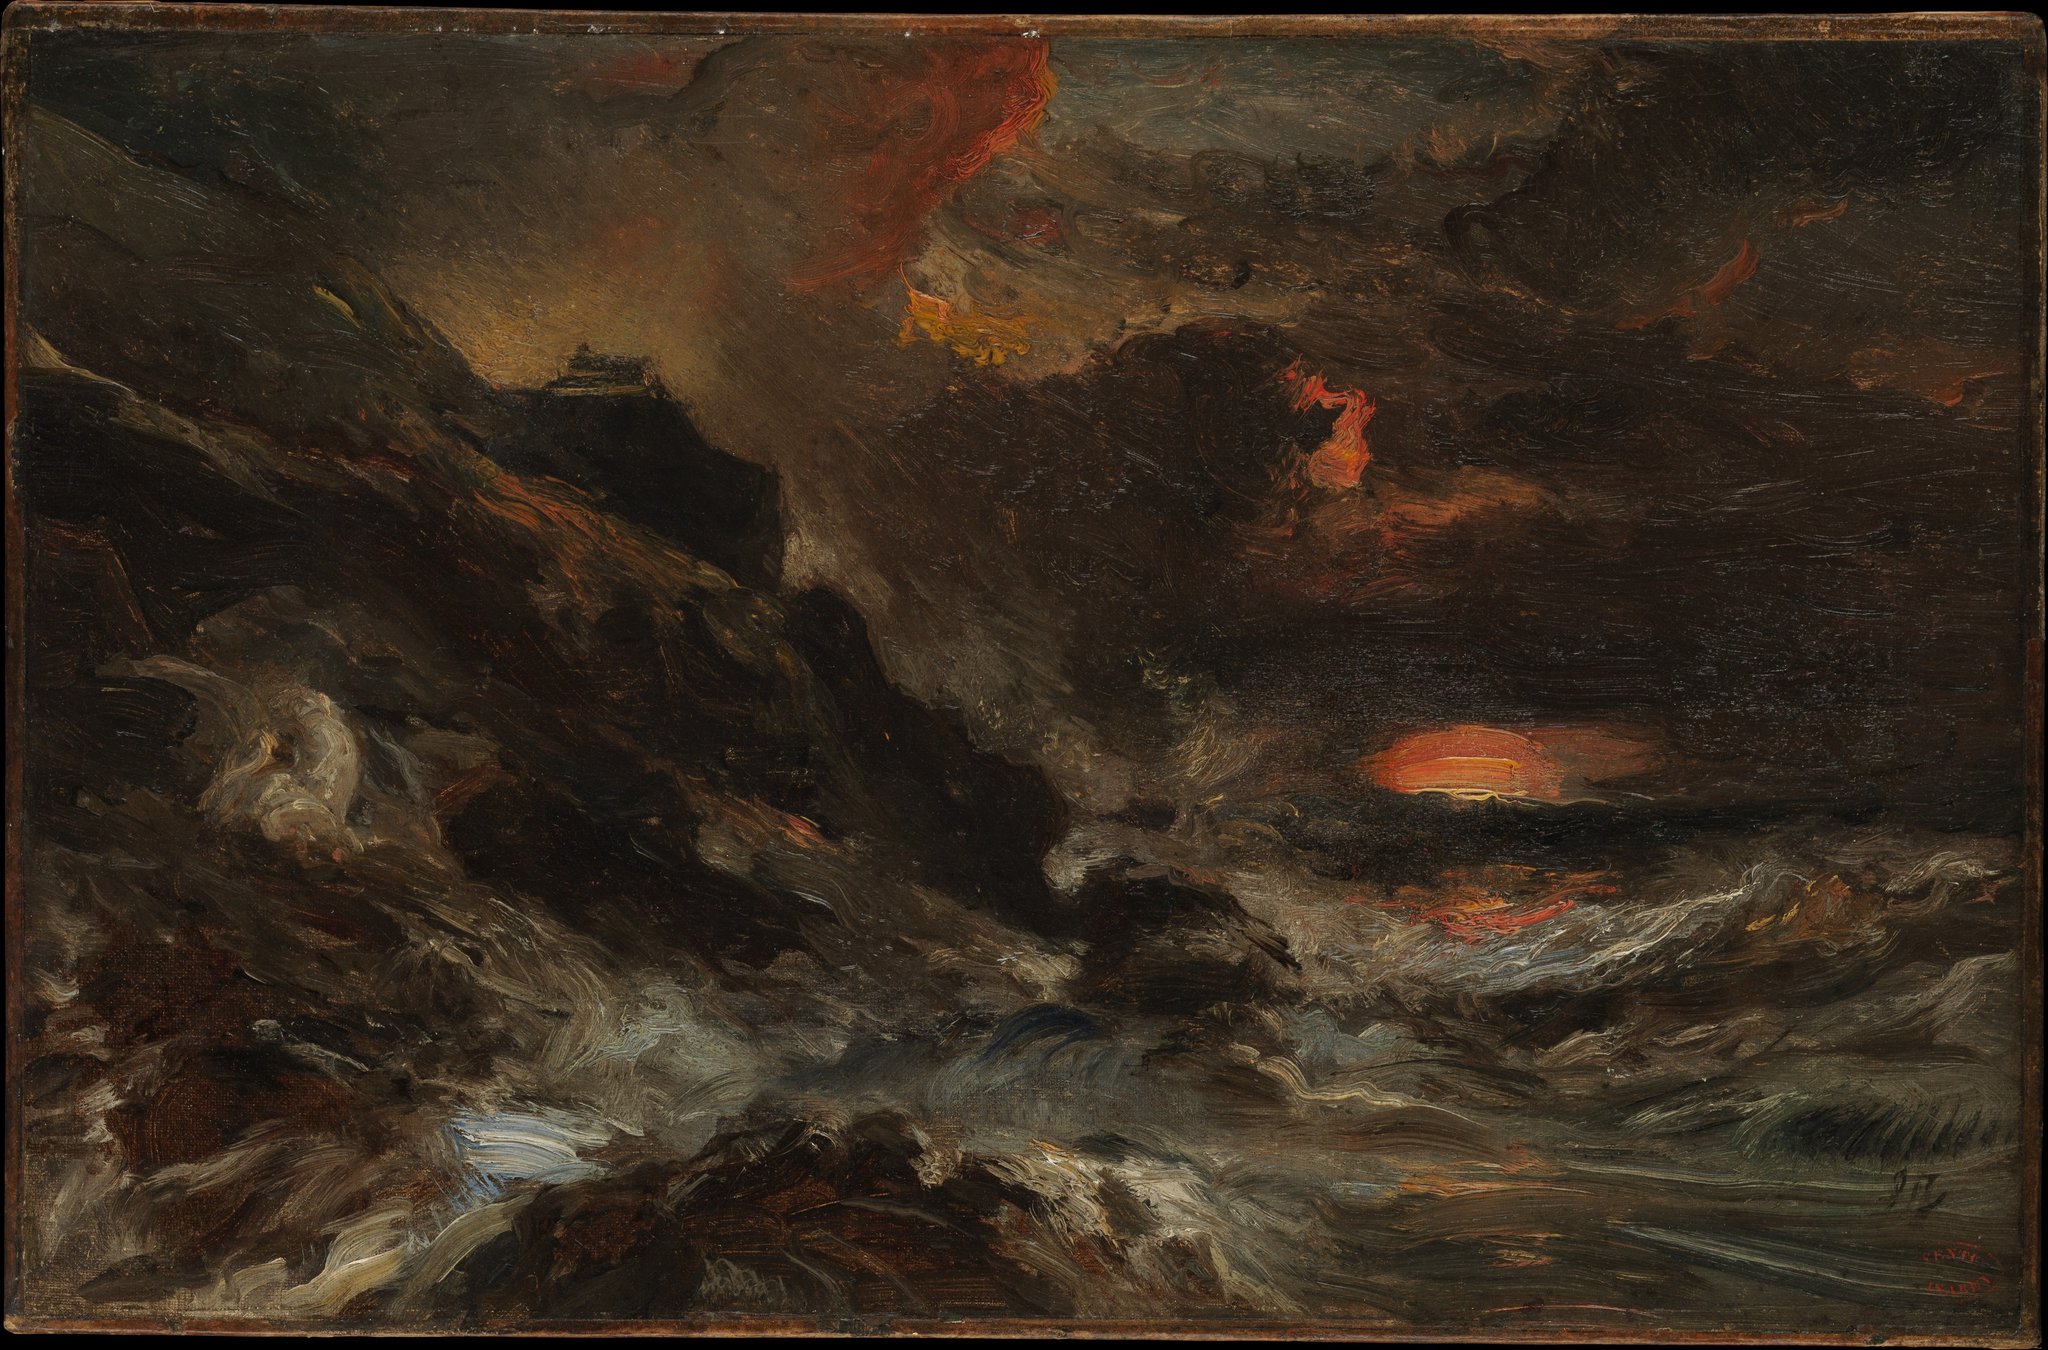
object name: painting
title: A Storm off the Normandy Coast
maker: eugène isabey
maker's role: artist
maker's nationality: french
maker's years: 1803-1886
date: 1850-1859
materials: canvas, oil, paper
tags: seascapes,waves,storms